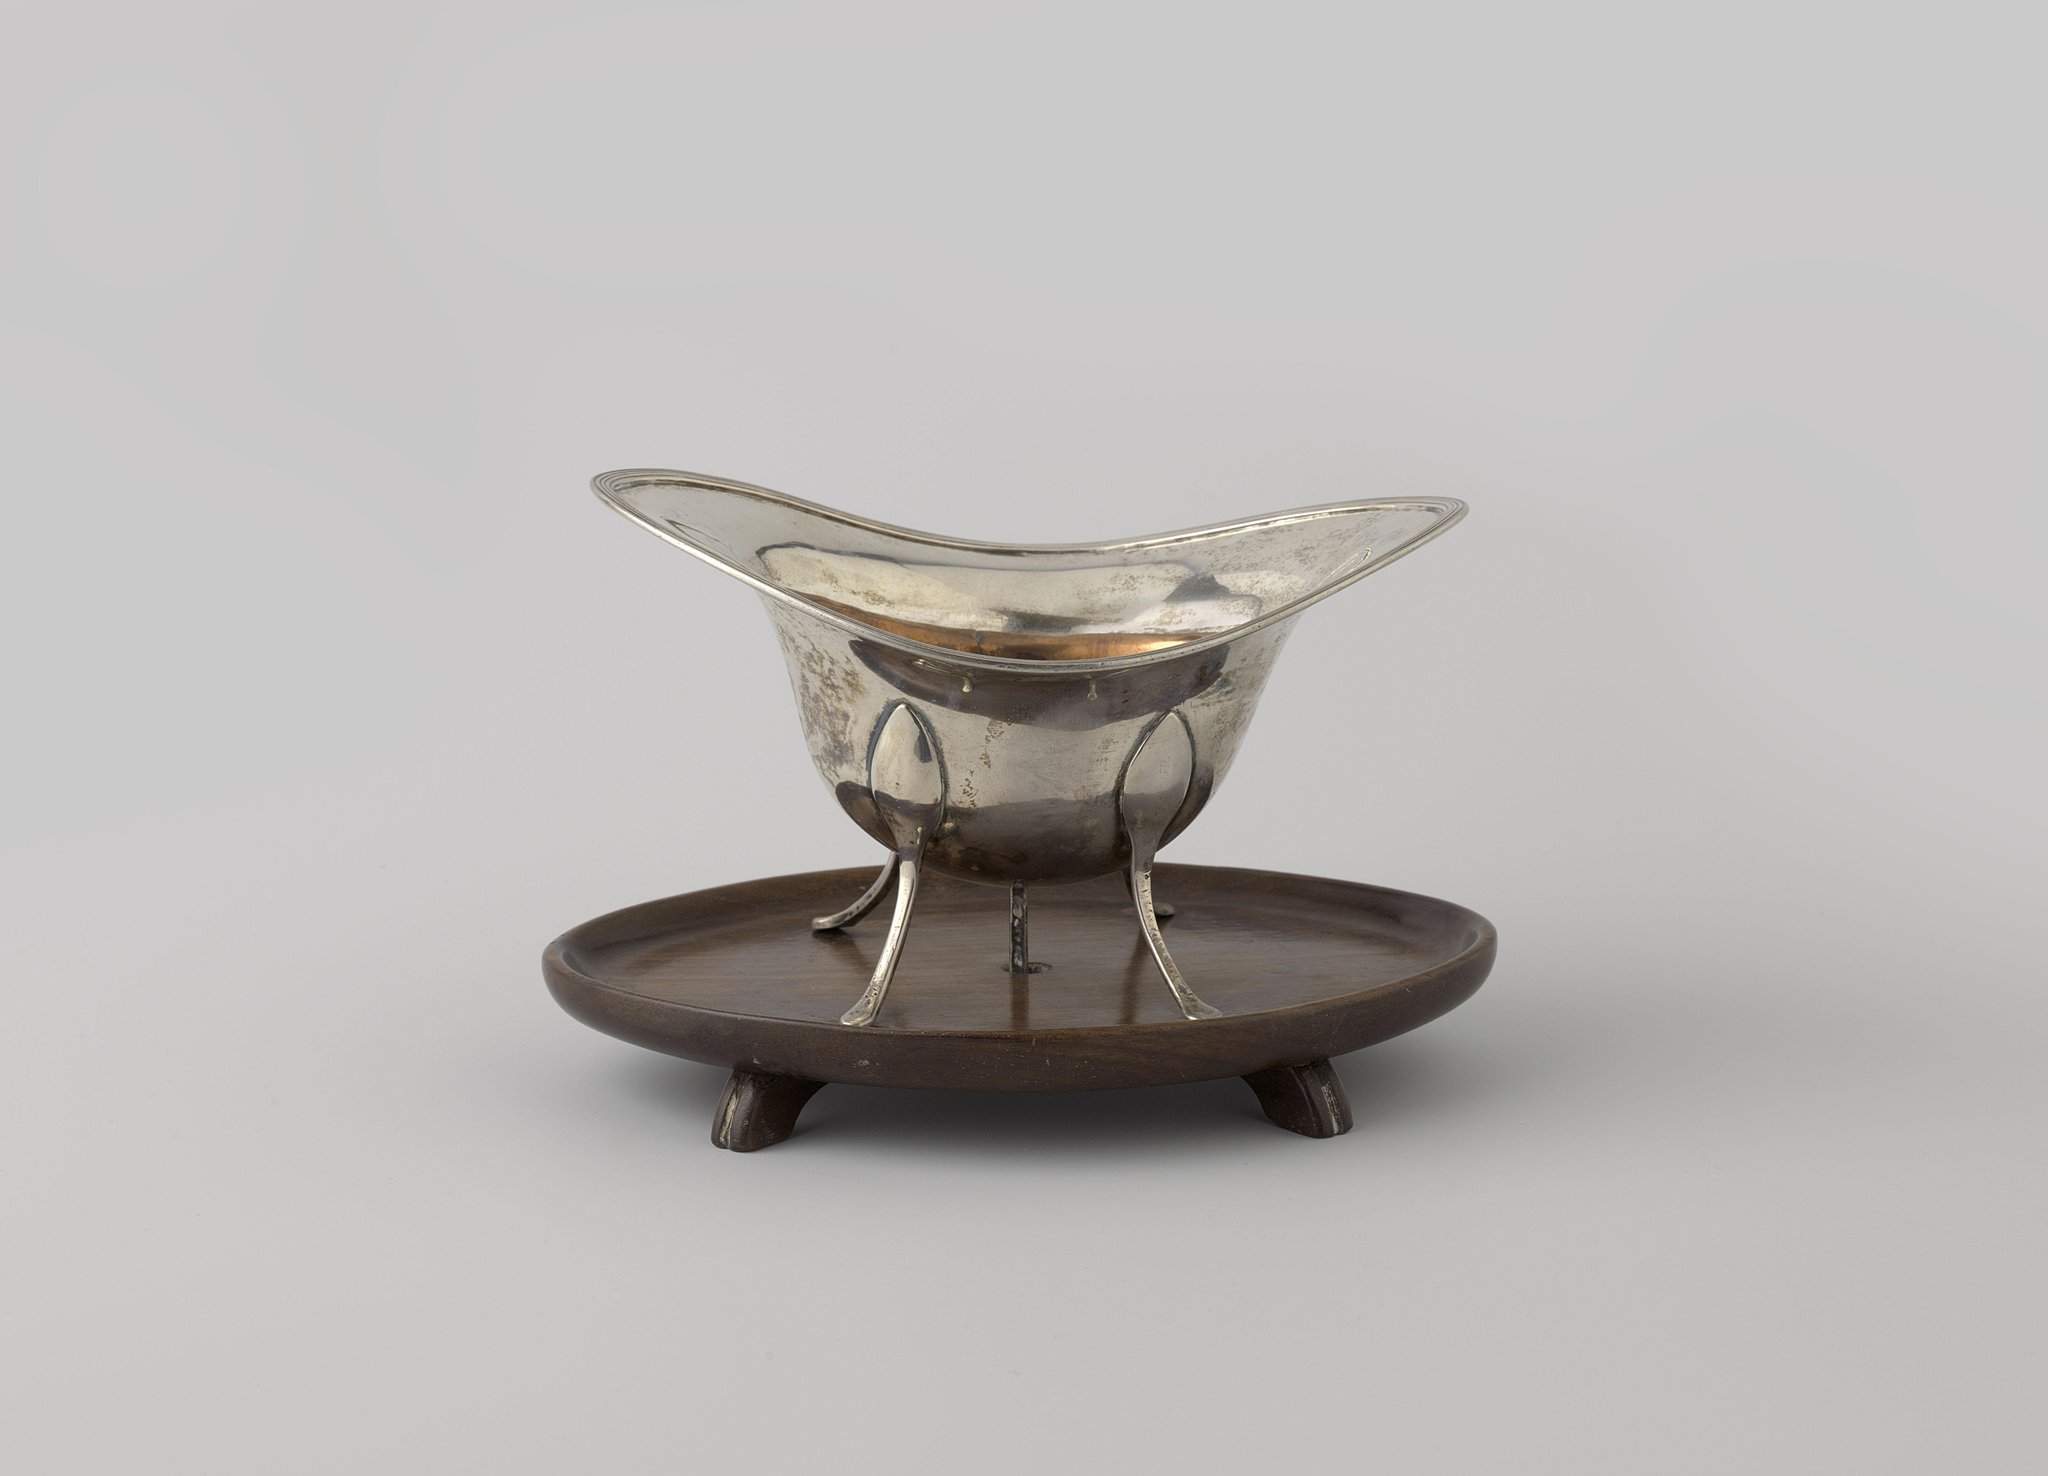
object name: pijpenkomfoor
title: Pijpenkomfoor van zilver op blad van mahoniehout en met binnenbak van rood koper. Gewelfd en aan beide zijkanten iets oplopend. Vier gebogen poten.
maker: jacob van nieuwcasteel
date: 1816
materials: copper, wood, silver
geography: utrecht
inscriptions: mark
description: Ovaal pijpenkomfoor van zilver met roodkoperen binnenbak, op een mahoniehouten blad. Het gewelfde, aan beide zijkanten iets oplopende komfoor rust op vier hoge, gebogen pootjes. Het blad rust op vier gebogen pootjes. De binnenbak, het komfoor en het blad, zijn door een zilveren moer met elkaar verbonden.